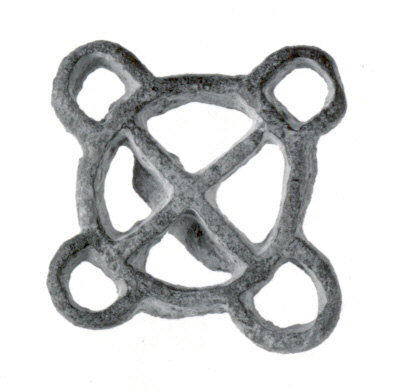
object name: stamp seal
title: Compartmented stamp seal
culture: bactria-margiana archaeological complex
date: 2333-1668 BCE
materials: copper alloy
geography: bactria-margiana